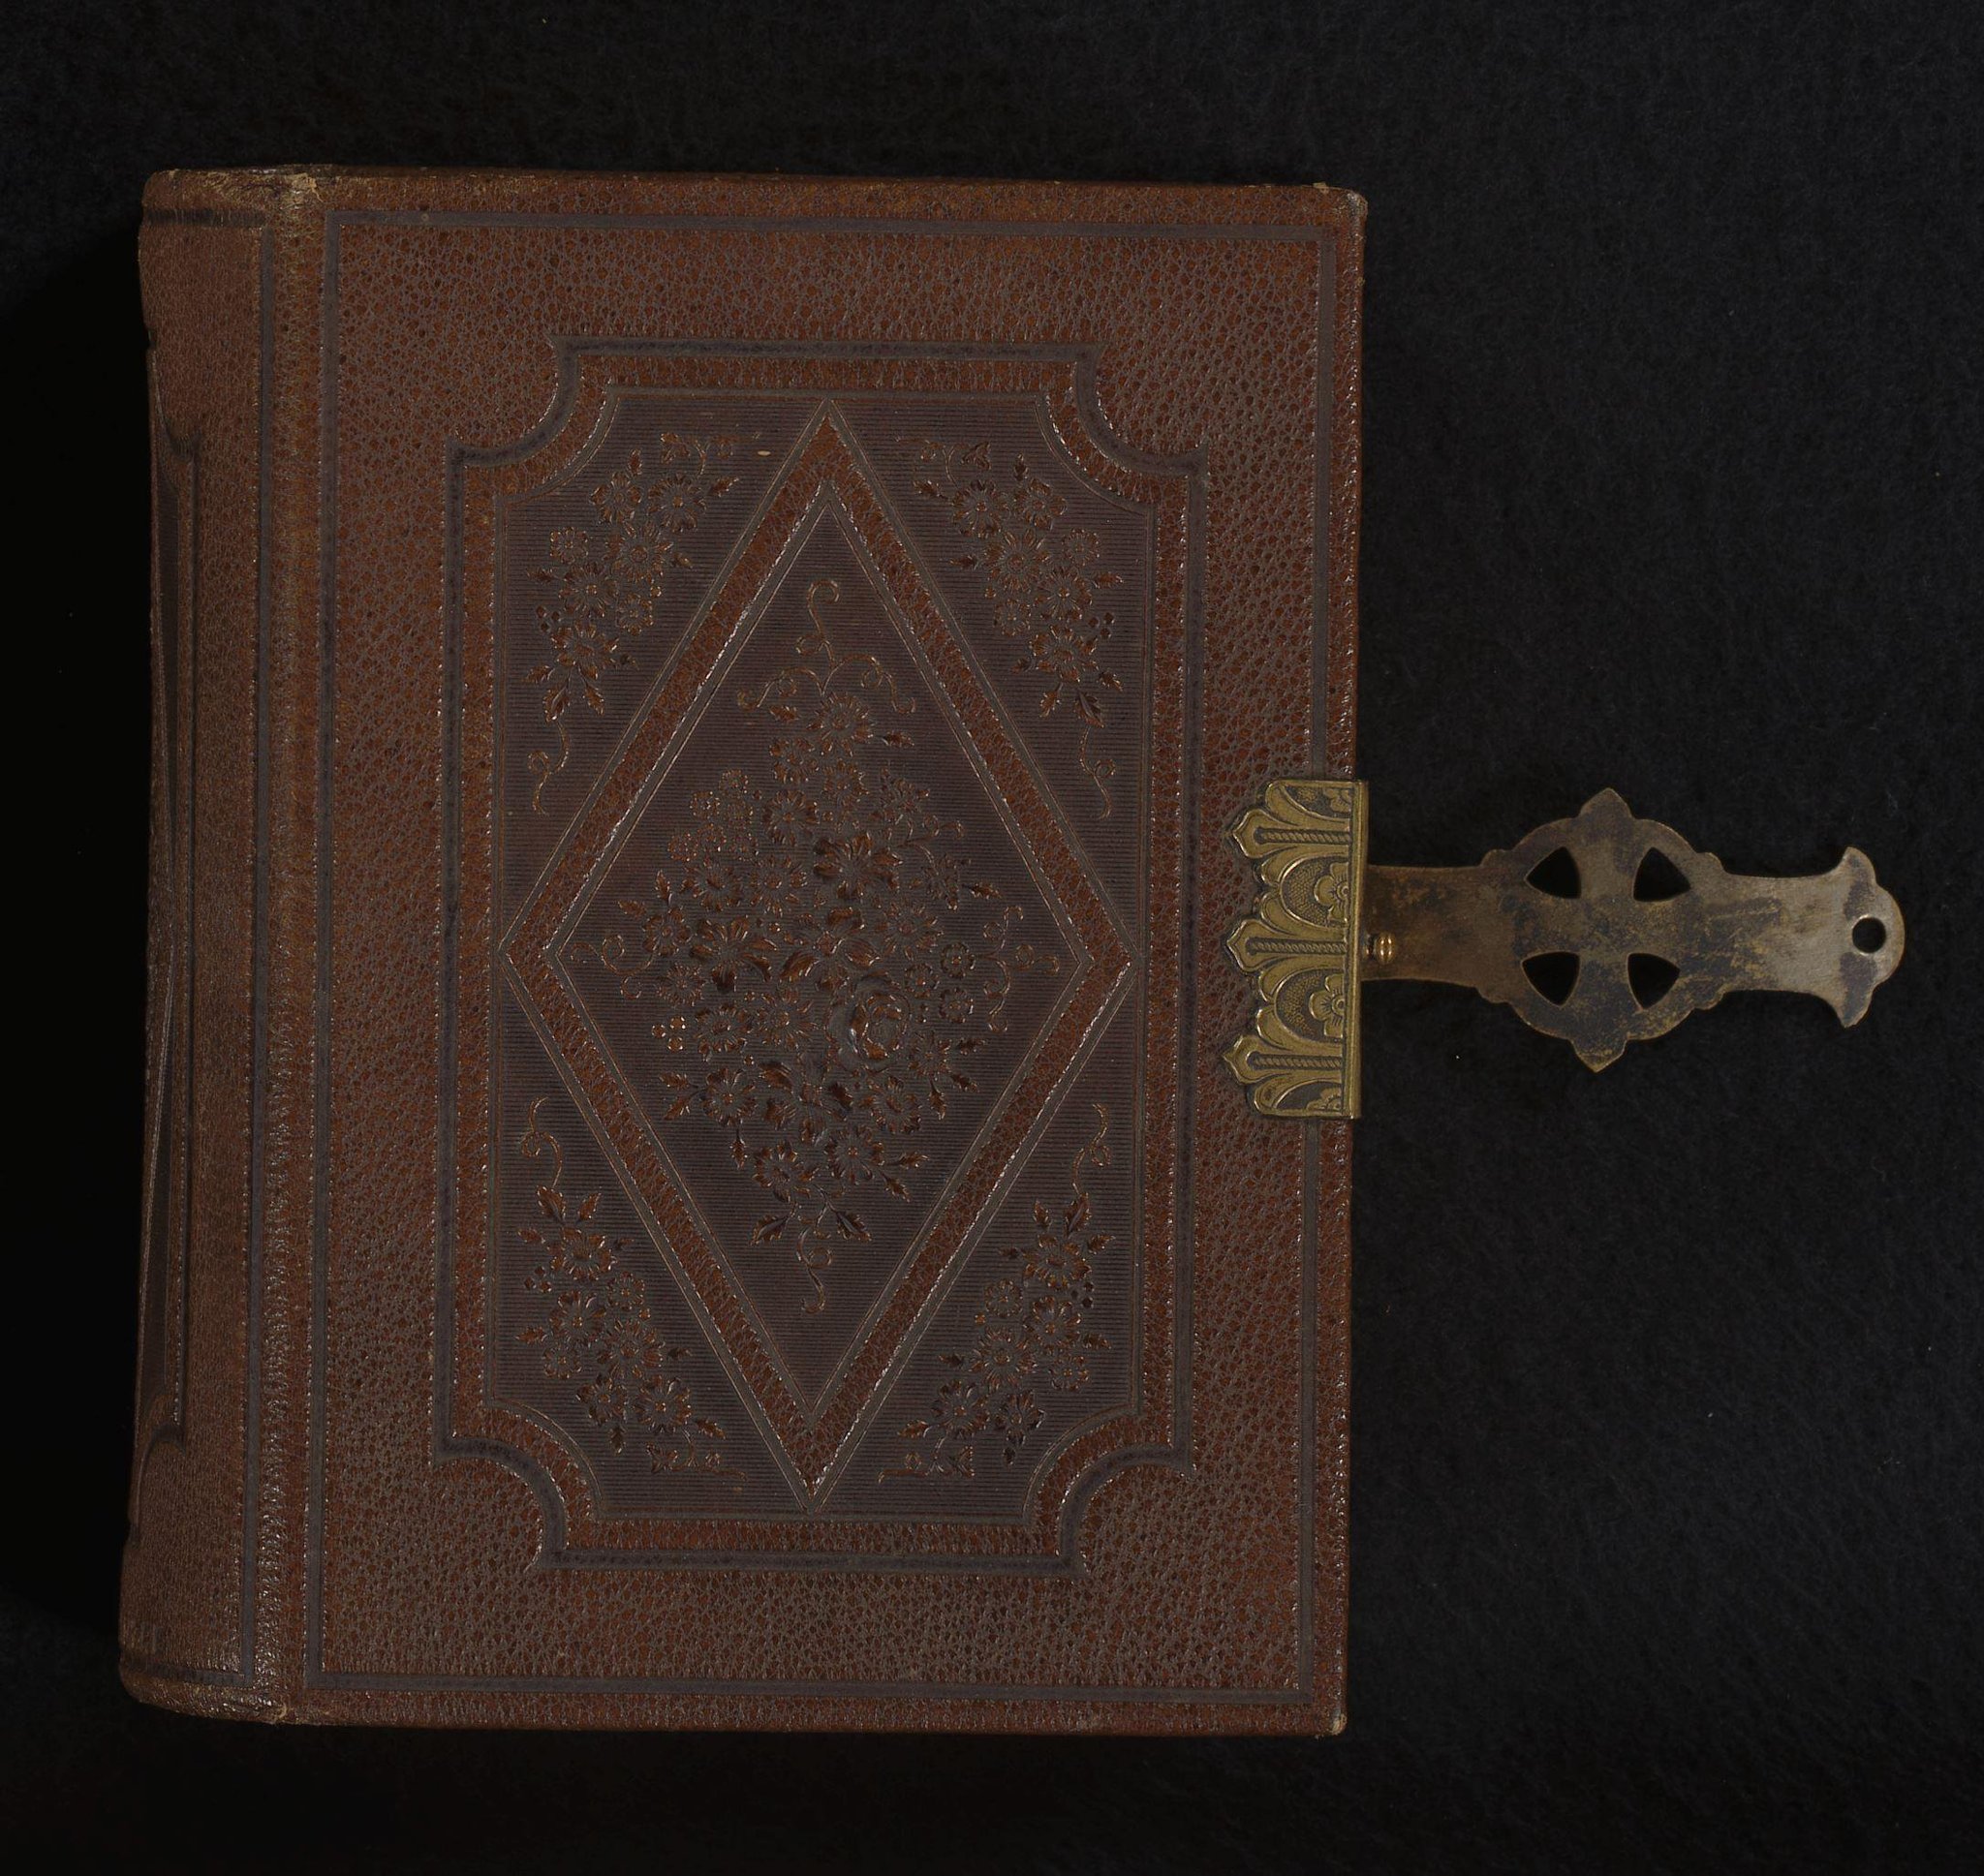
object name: photograph album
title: Fotoalbum (leeg)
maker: Anonymous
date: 1860-1900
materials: cardboard, leather, metal, paper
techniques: color on snow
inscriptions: collector's mark: ‘DIENST/ VERSPREIDE/ RIJKSKOLLEKTIES/ (...) A808’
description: Fotoalbum met 48 pagina's met ieder een met gepreegde rand omkaderde passe-partout voor een carte-de-visite. Op de rug van het album is de naam Antoine Maitre gepreegd.